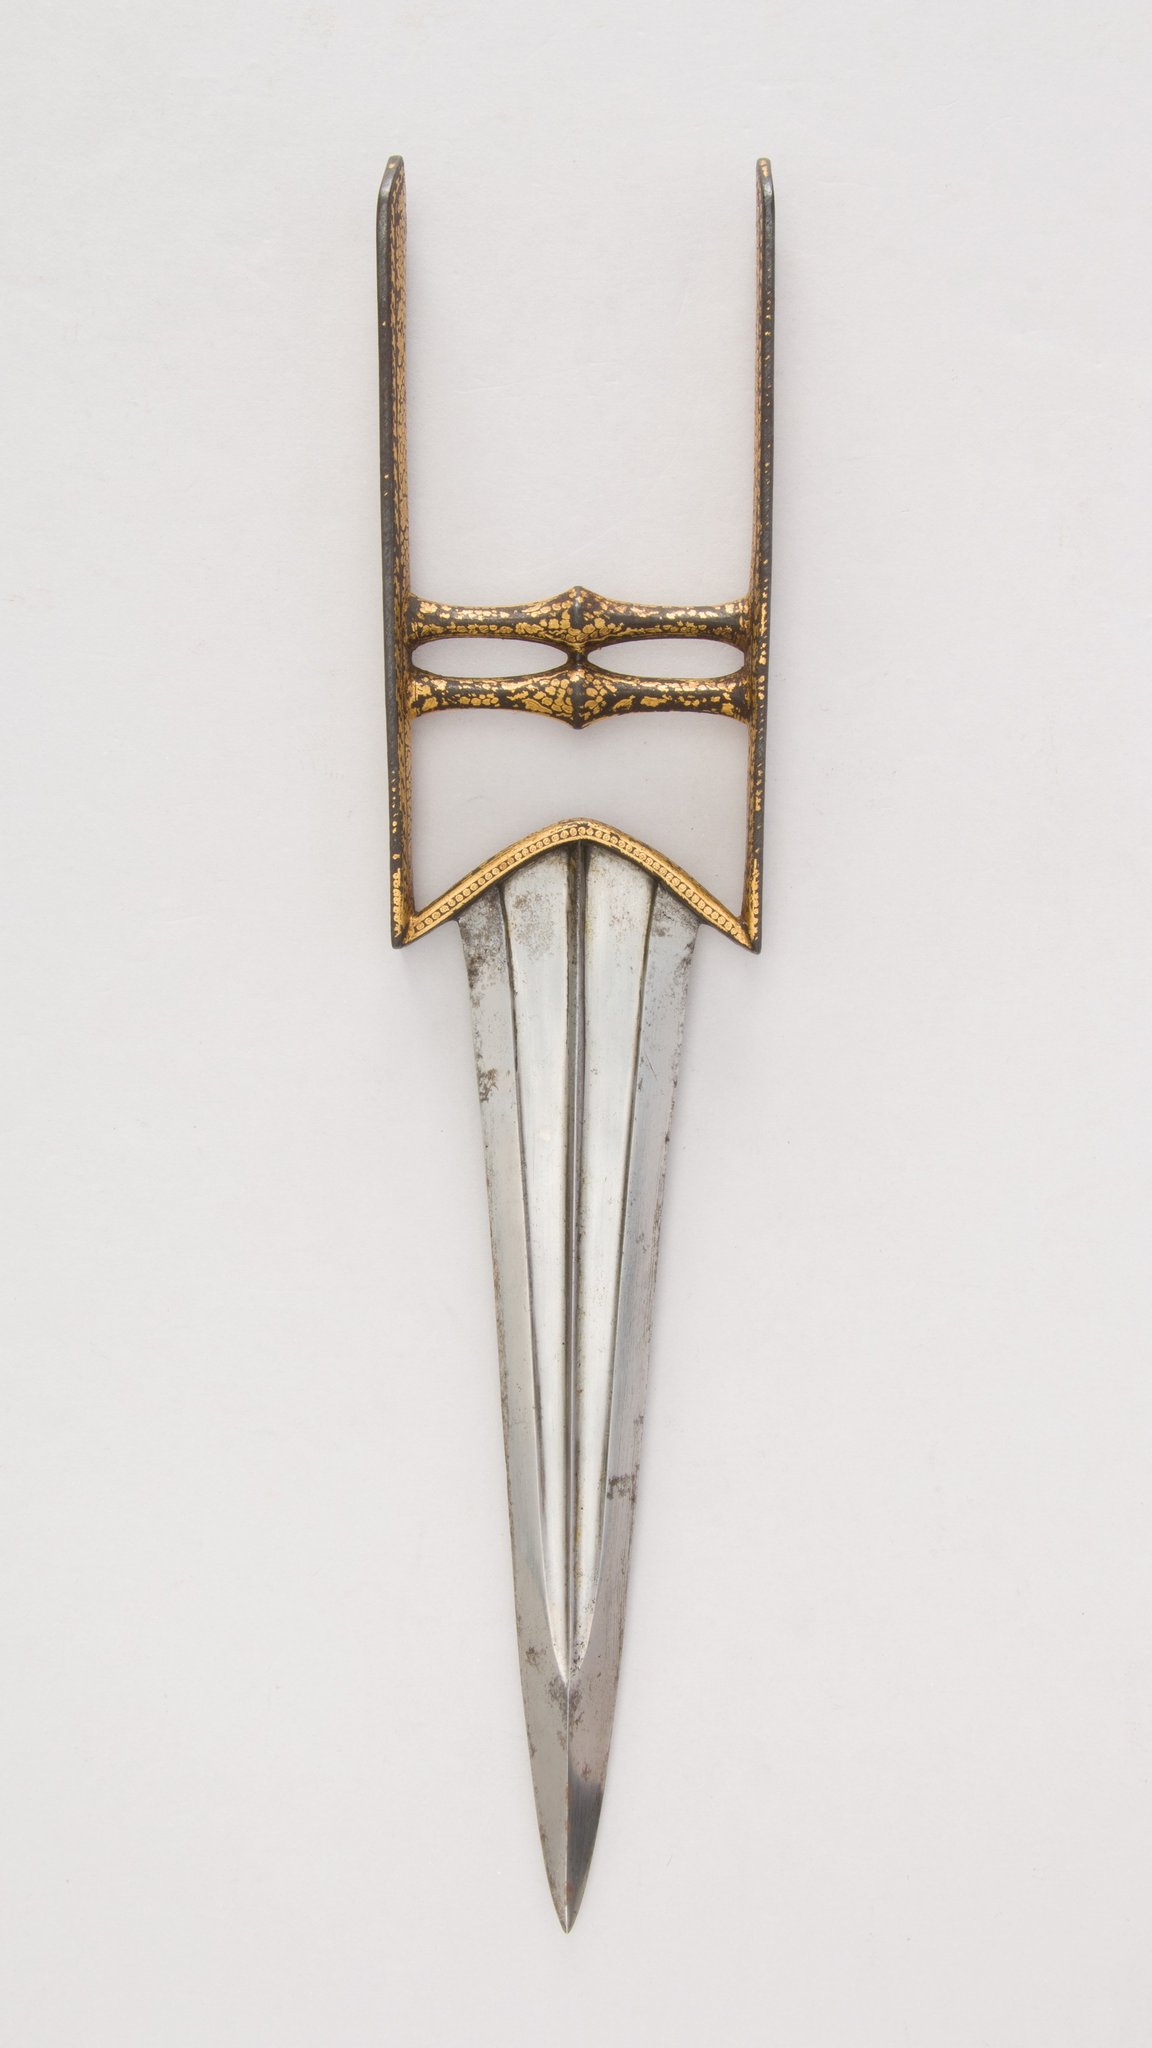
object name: dagger katar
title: Dagger (Katar)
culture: indian, mughal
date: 1701-1900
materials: gold, steel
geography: india